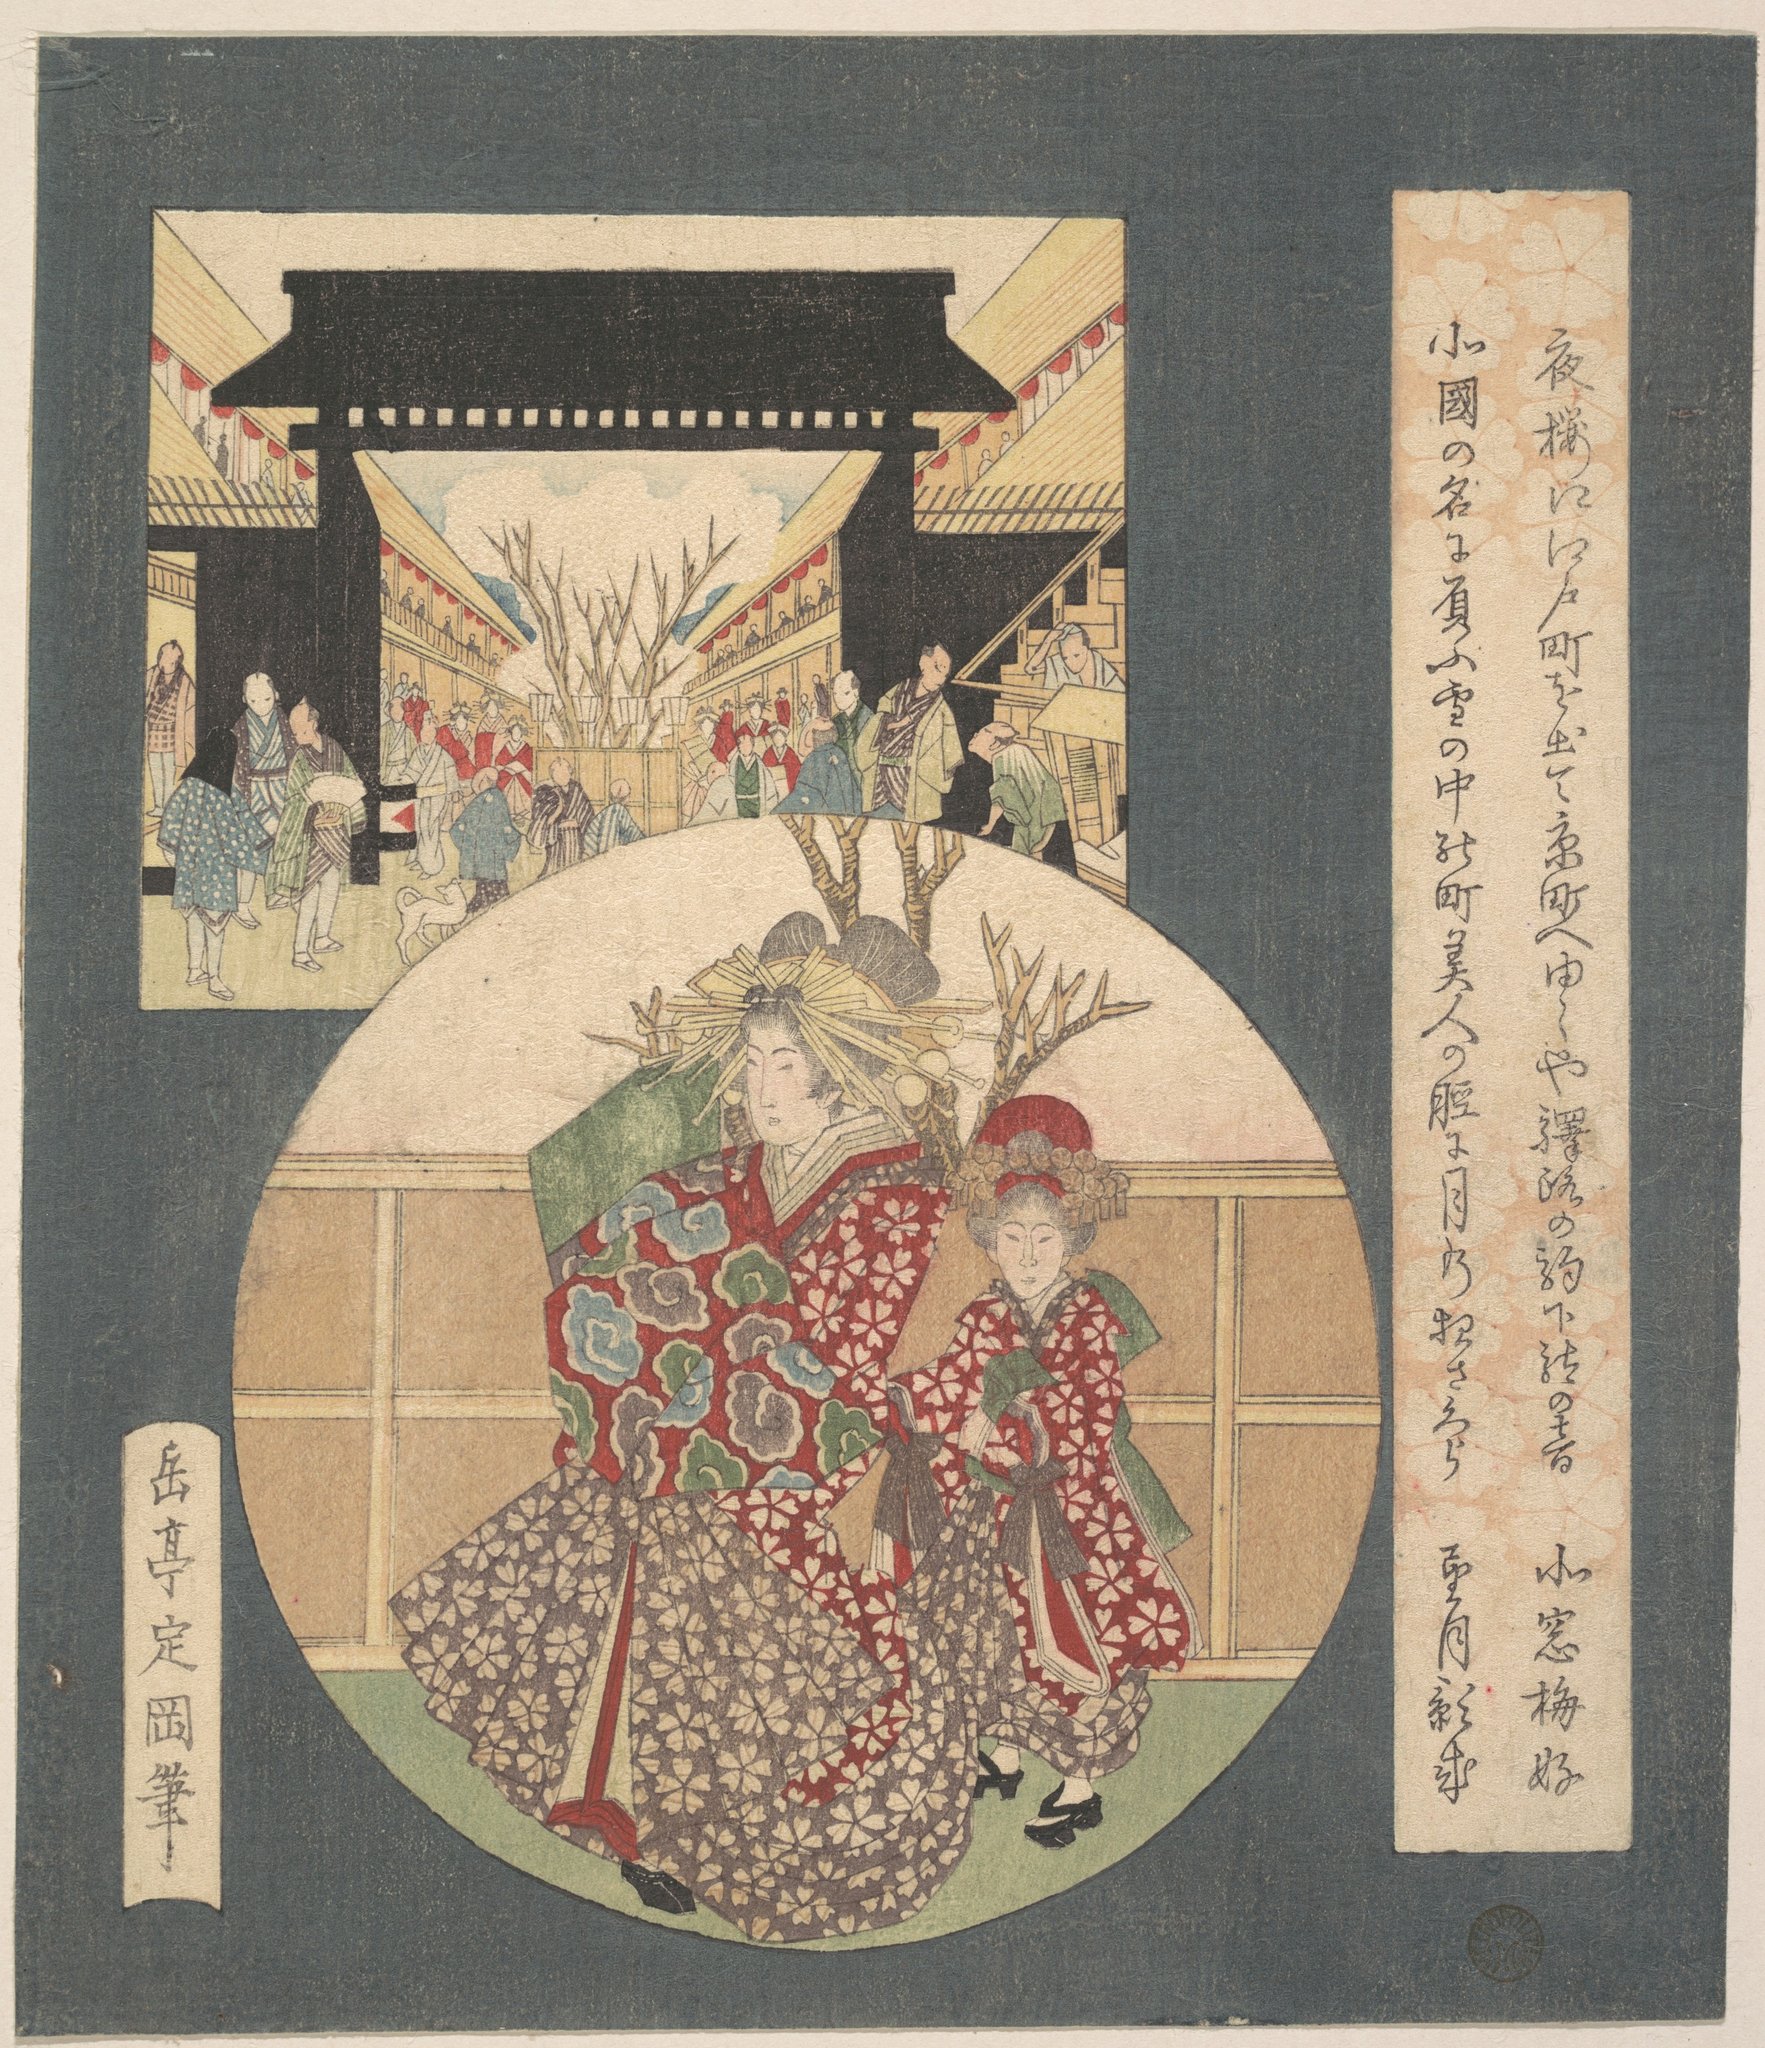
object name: print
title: The Gate of the Yoshiwara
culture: japanese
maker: yashima gakutei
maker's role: artist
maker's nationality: japanese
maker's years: 1786-1868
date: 1820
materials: ink, paper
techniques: surimono, woodblock print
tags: gates,women